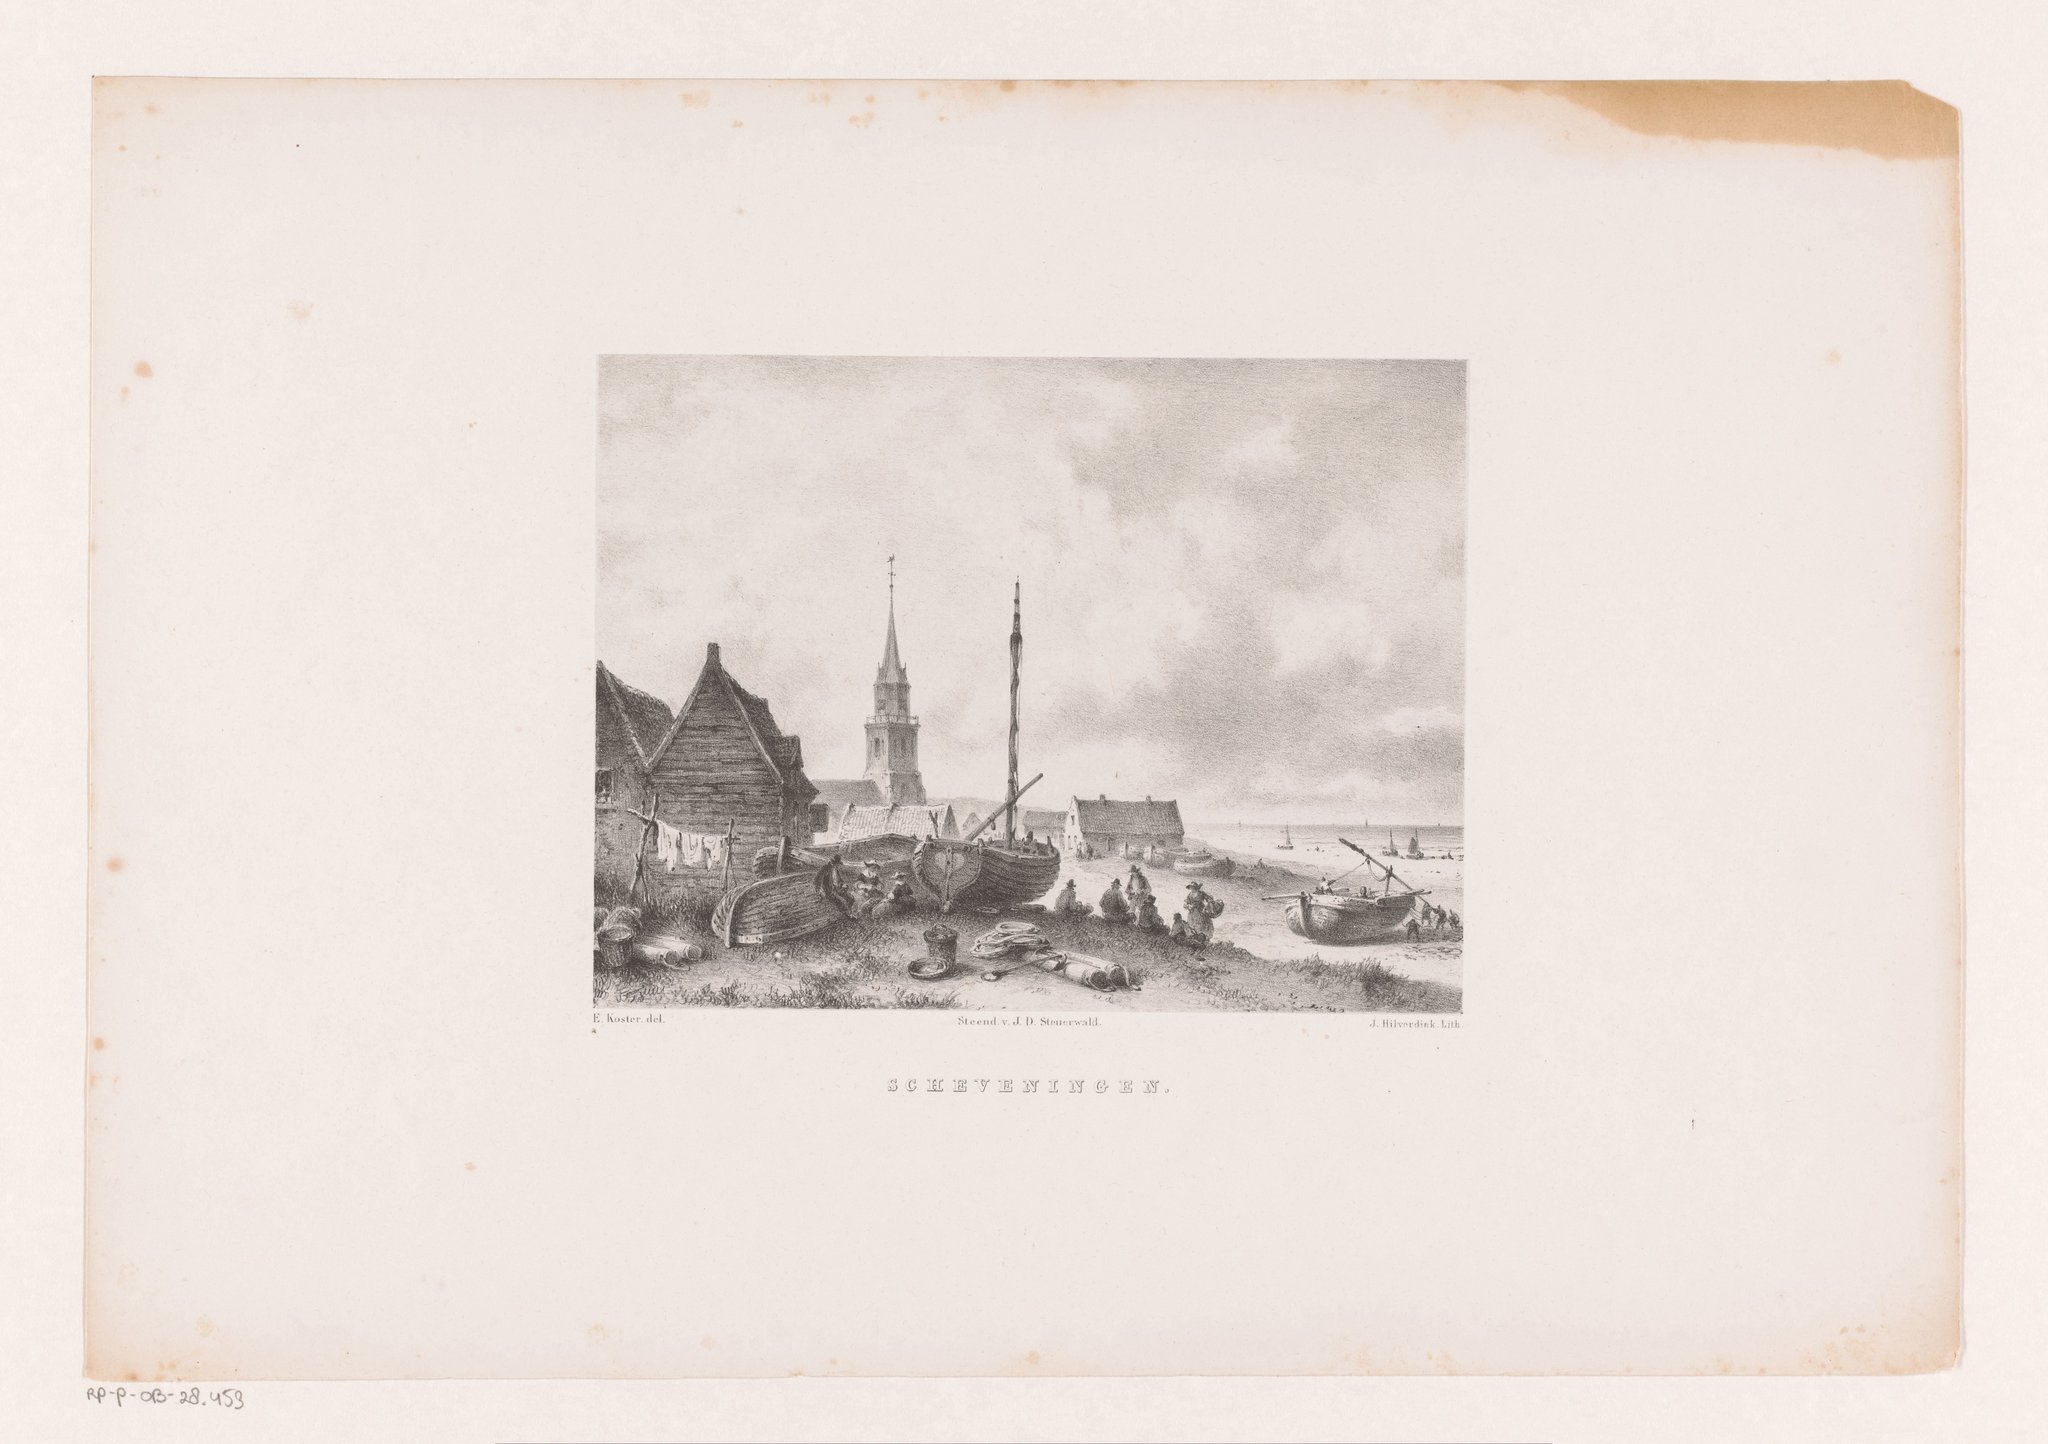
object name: print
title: Scheveningen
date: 1858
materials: paper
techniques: lithograph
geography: amsterdam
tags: ships, boats on land, beached, beach (+ landscape with figures, staffage)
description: Deze prent komt uit: Koster, E. 'E. Koster's schetsboek: Nederlandsche Stads- en Havengezichten, uitgegeven onder medewerking van de maatschappij Arti et Amicitiae, Amsterdam, F. Buffa en Zn., e.a.' Amsterdam 1858.